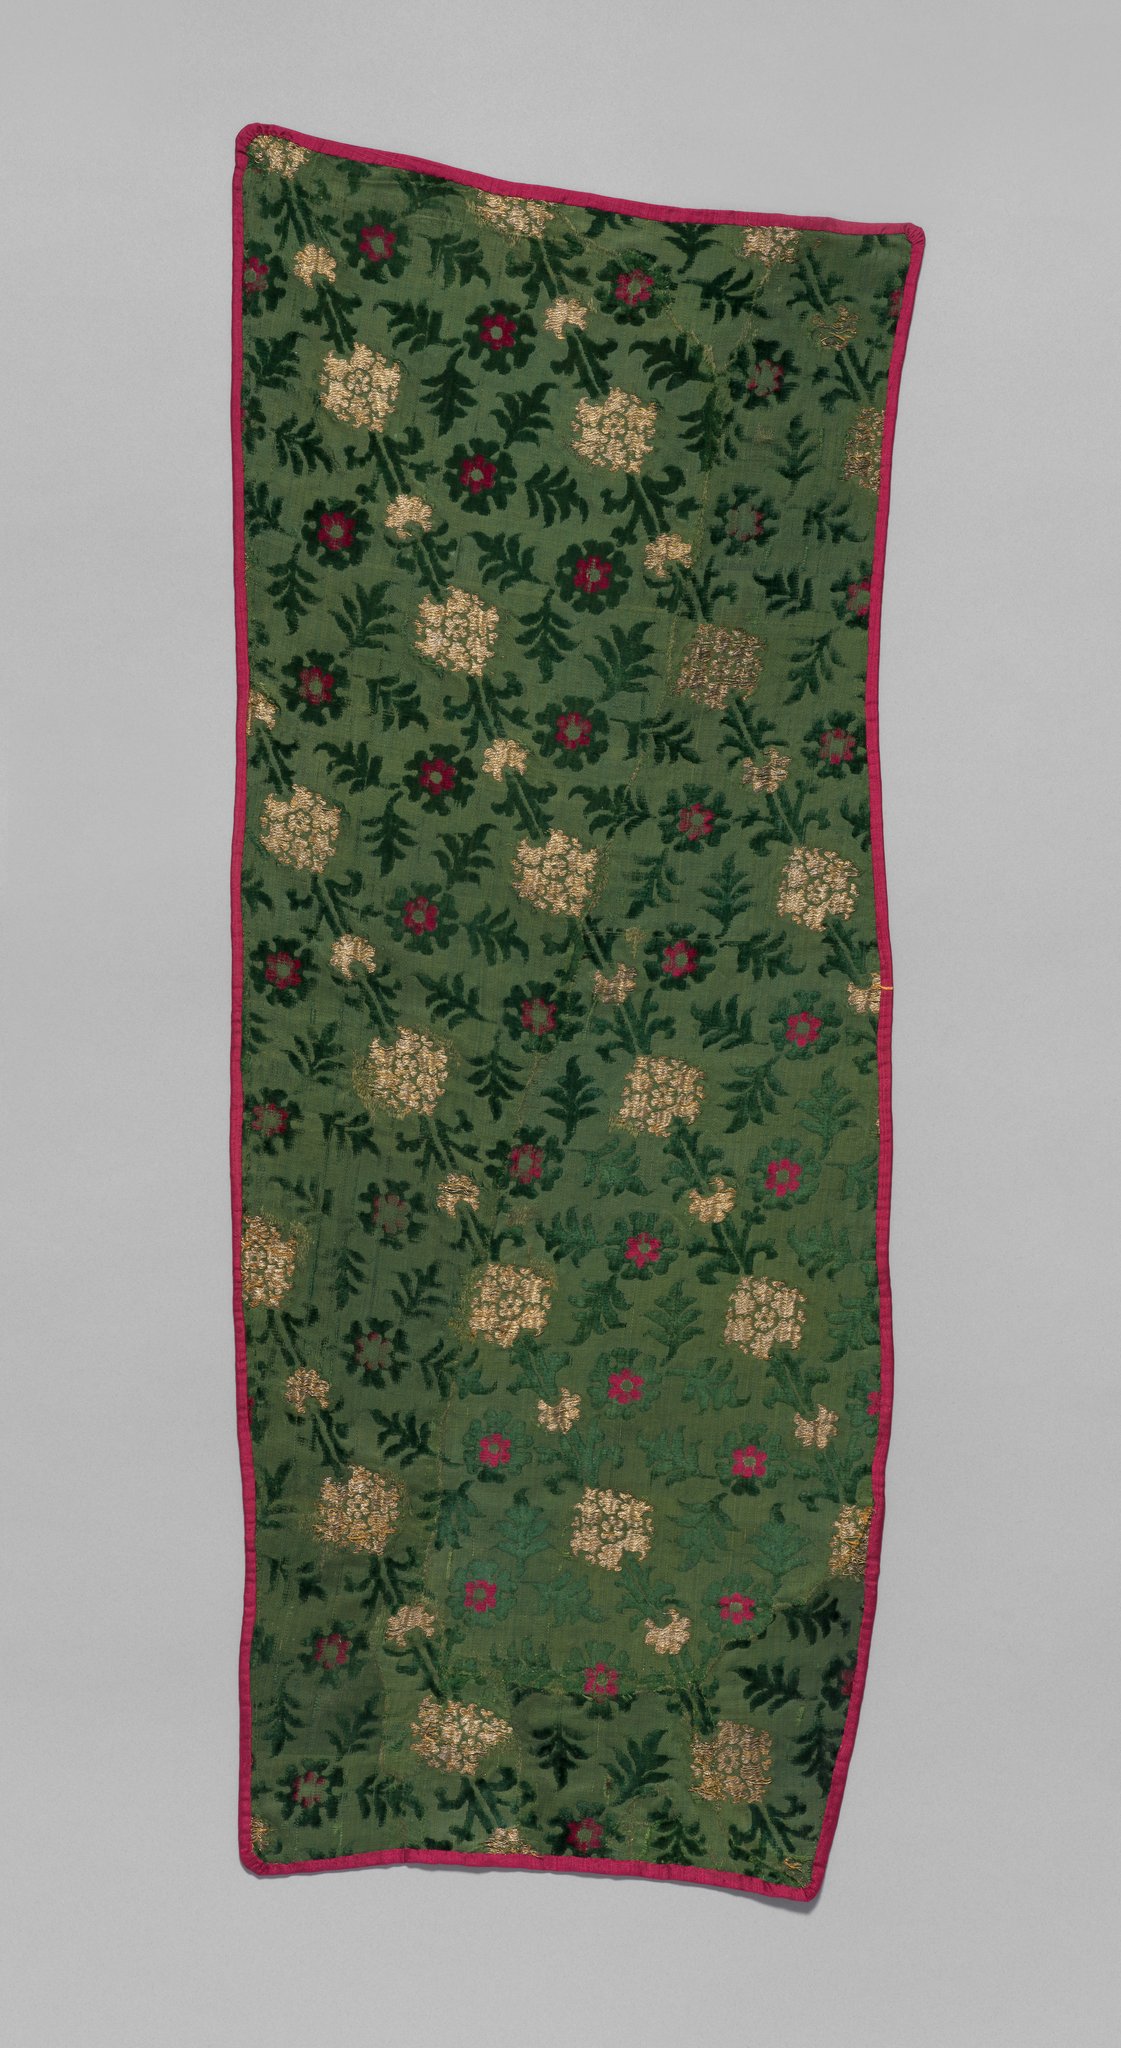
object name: panel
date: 1434-1466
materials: metal thread, silk